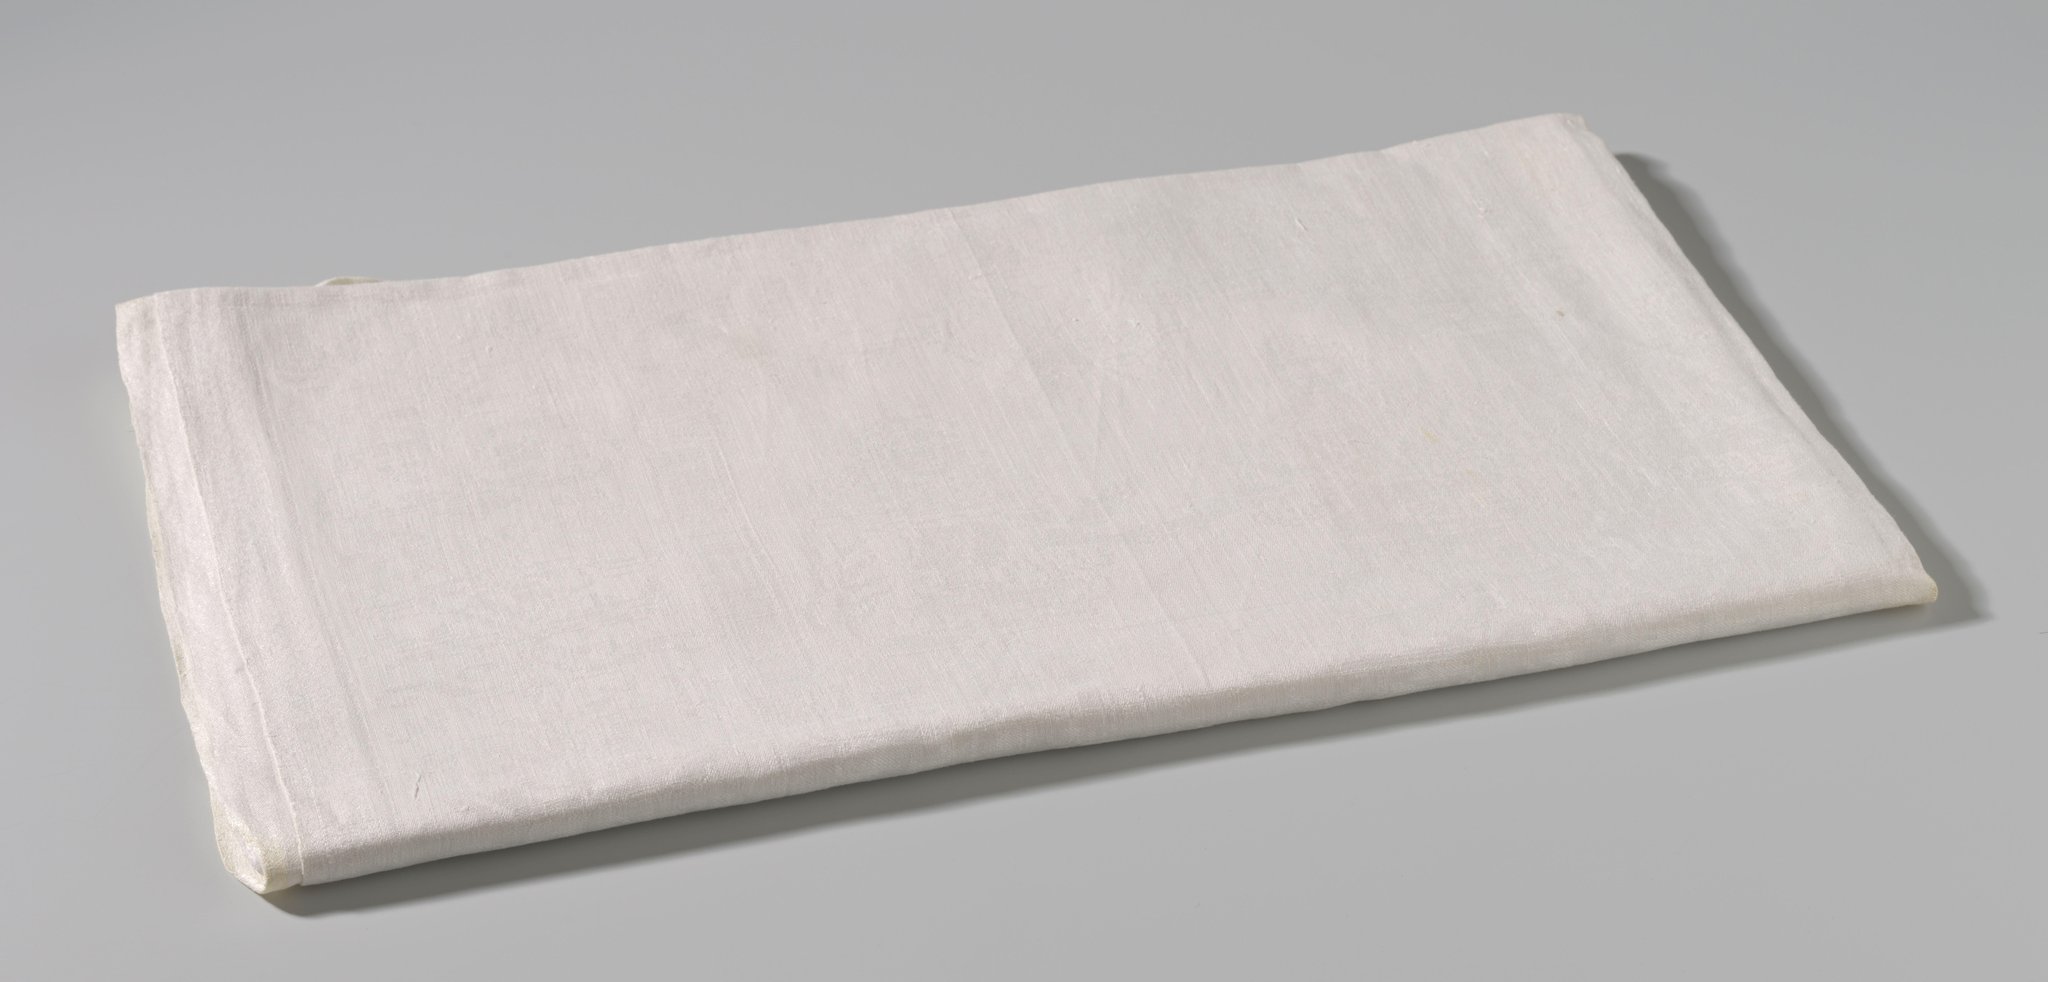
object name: tablecloth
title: Tafellaken met Lodewijk XV, koning van Frankrijk, en Maria Lesczinska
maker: Anonymous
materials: linen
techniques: damask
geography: kortrijk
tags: maria lesczinska (koningin van frankrijk), louis xv of france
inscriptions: mark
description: Tafellaken van linnendamast met Lodewijk XV en Maria Lesczinska. Middenveld: Het symmetrisch, driemaal naast elkaar en tweemaal boven elkaar herhaalde patroon vertoont drie taferelen: 1 Vliegende engelen houden een verdubbeld medaillon op, waarin de tekst: VIVANT LUDOVICUS MARIA REX ET REGINA. 2 Een staande figuur in koningsmantel en een vrouw elkaar de hand reikende en staande op een tegelterras onder een dubbelgezwenkte boog, gesteund door zuilen met Ionisch kapiteel. 3 Door palmtakken gedragen, gekroond alliantiewapen: het middelste, waarop drie lelies, wordt geflankeerd door een ovaal schild dat gevierendeeld is: 1 en 4 een dubbele adelaar, 2 en 3 een ruiter; hartschild met ossenkop. Ter weerszijden zwevende engelen met bazuin, waaraan een vaan met de letter L. Randen: binnen recht lijstwerk stam met voluttbladeren, steeds gevarieerd en kleine hartvelden met geschaakt dessin. Rondom: blokkenrand.